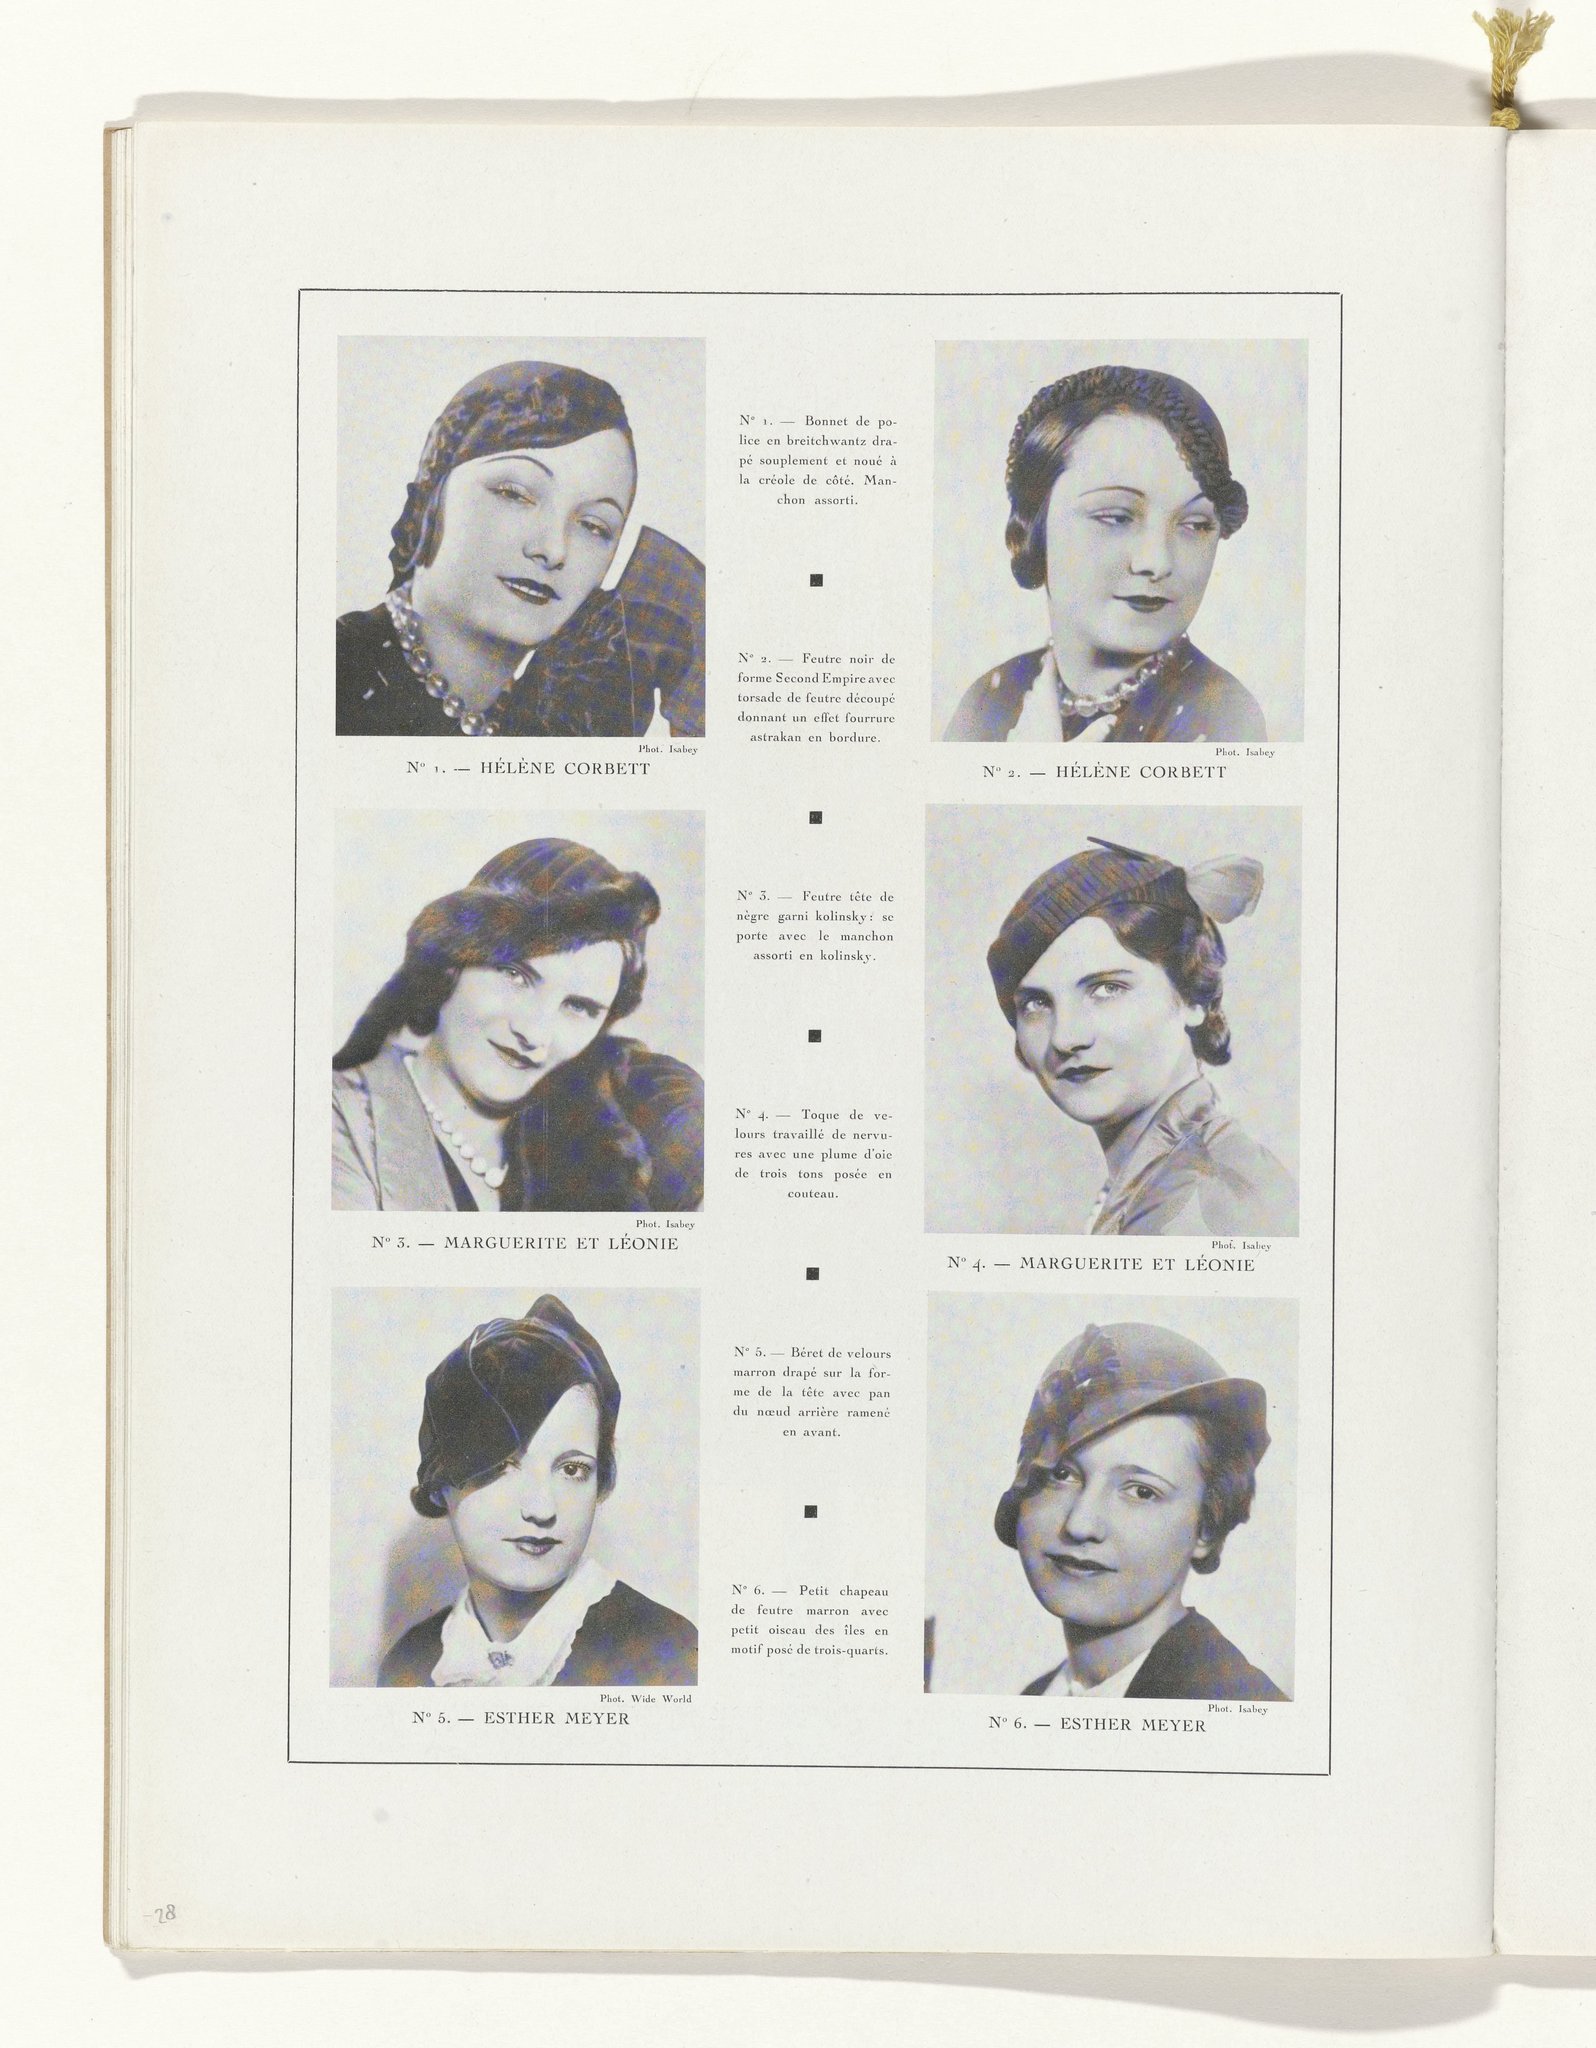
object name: magazine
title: Art - Goût - Beauté, Feuillets de l' élégance féminine, Novembre 1931, No. 135, 12e Année, p. 28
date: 1931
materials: paper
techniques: photography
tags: head-gear: toque (+ women's clothes), head-gear: beret (+ women's clothes), head-gear: cap (+ women's clothes), fashion plates, head-gear: hat (+ women's clothes)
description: Zes verschillende dameshoeden, genummerd 1 tot en met 6. No. 1 en 2 van Hélène Corbett. No. 3 en 4 van Marguerite et Léonie. No. 5 en 6 van Esther Meyer. Pagina uit het modetijdschrift Art-Goût-Beauté (1920-1933).